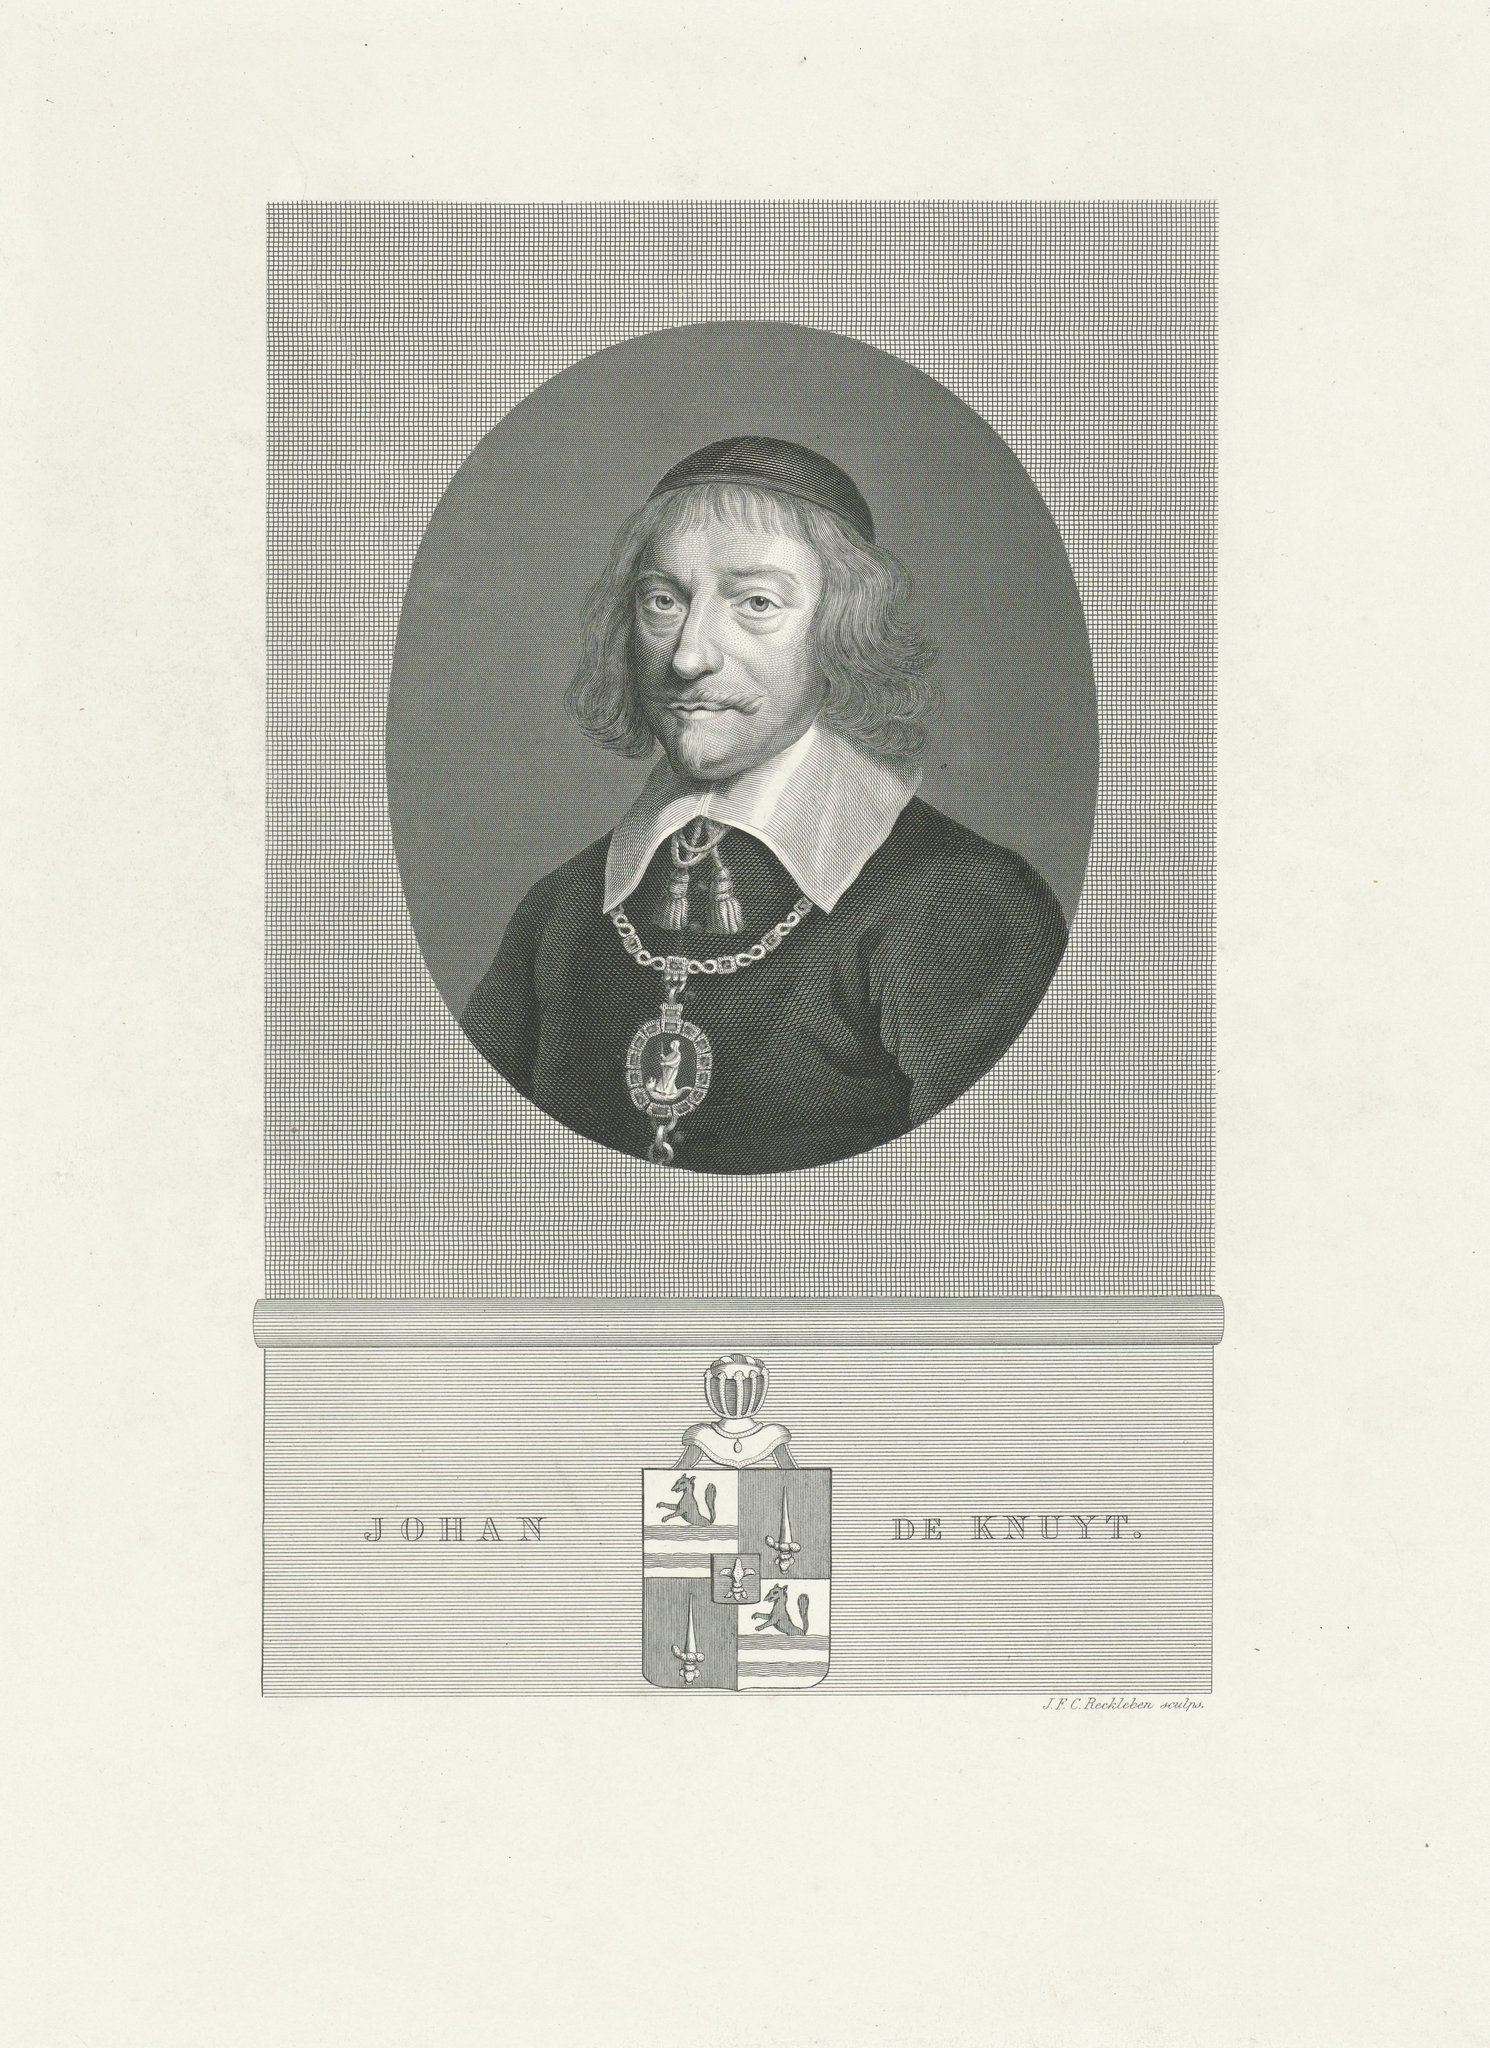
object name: print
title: Portret van Johan de Knuyt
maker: jan frederik christiaan reckleben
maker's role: print maker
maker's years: 1819-1879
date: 1861-1863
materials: paper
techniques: engraving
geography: amsterdam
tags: johan de knuyt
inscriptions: collector's mark: Lugt 2228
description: Illustratie in: Arend, Johannes Pieter. Algemeene geschiedenis des vaderlands van de vroegste tijden tot op heden. 5 delen, Amsterdam: Schleijer, J.F. 1840-1884, dl. 3.4, p. 810.